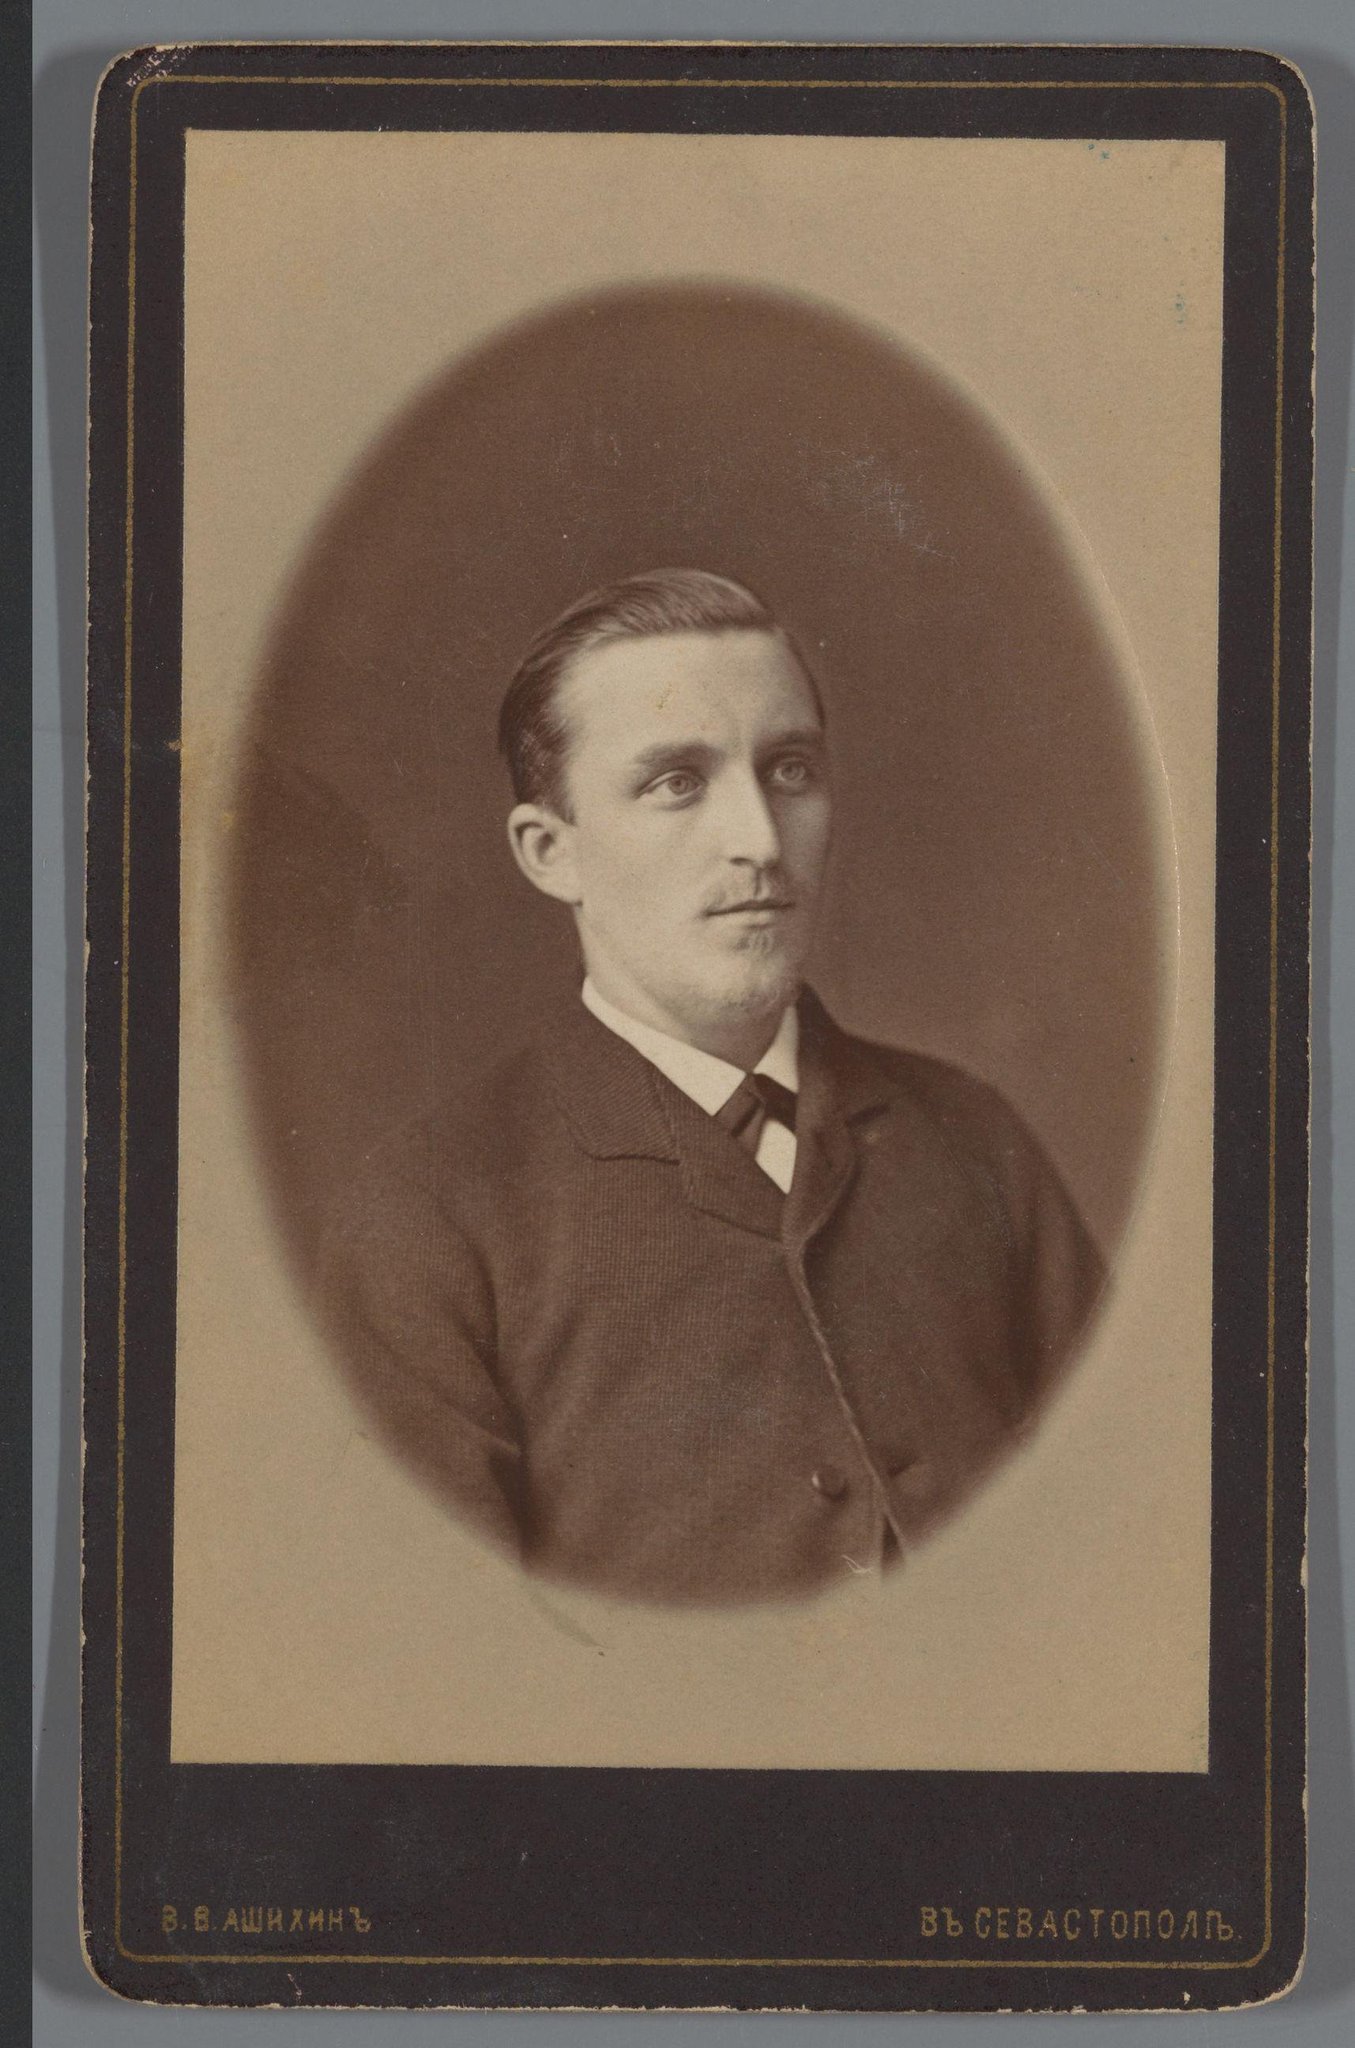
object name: carte de visite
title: Portret van een onbekende man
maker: w.w. atsichina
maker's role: fotograaf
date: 1880-1910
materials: cardboard, paper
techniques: albumen print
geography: sebastopol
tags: adult man, anonymous historical person portrayed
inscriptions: inscription: ‘W.W. Atsichina V Sevastopol’, monogram: ‘BB’, inscription: ‘Fotografja/ Atsichina/ (...) V Sevastopol.’